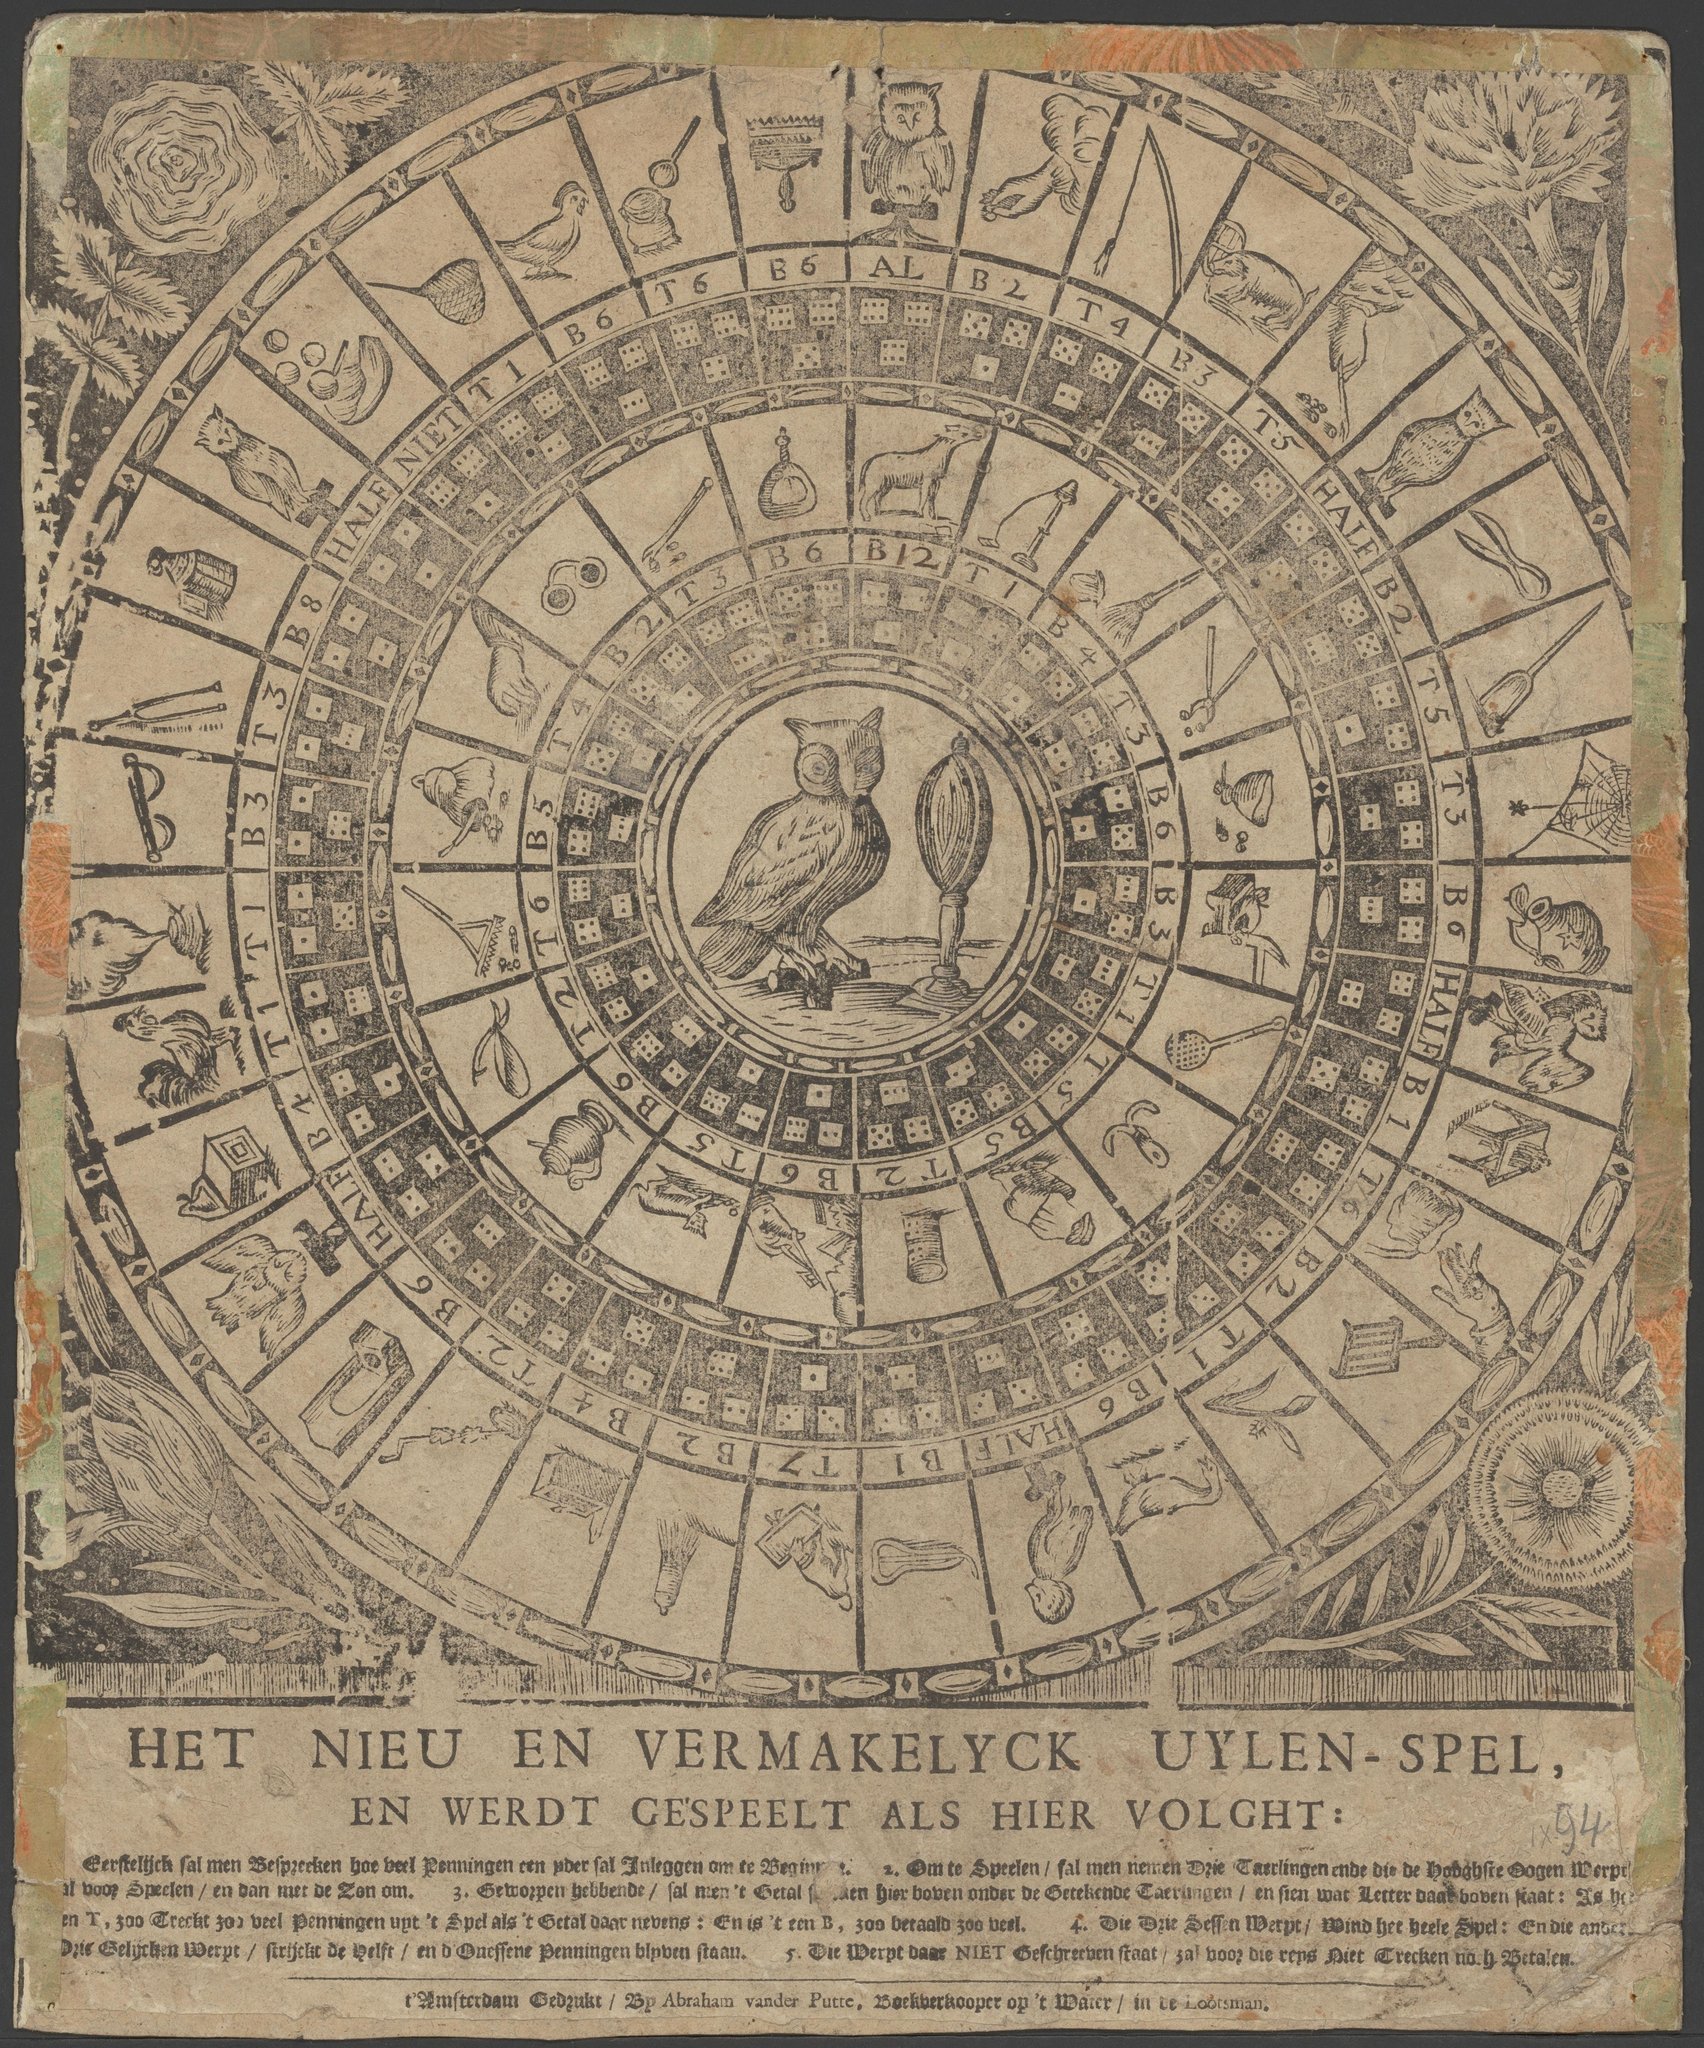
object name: gameboard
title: Het nieu en vermakelyck uylen-spel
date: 1748-1760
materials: paper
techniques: letterpress printing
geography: amsterdam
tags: board-games of chance, birds, mirror, board-games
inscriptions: collector's mark: Lugt 1641, stamp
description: Een bordspel met in het midden een uil met een spiegel. Daaromheen in cirkels vakken met voorwerpen, dieren en dobbelstenen. In de vier hoeken afbeeldingen van bloemen. Onder de voorstelling de spelregels in gotische letters. Onderwerpsrubrieken binnen de Atlas Zeden en Gewoonten: Zeden en gewoonten in engeren zin, Spel en vermaak, Gezelschapsspel II, Ganzenbord en dergelijke.